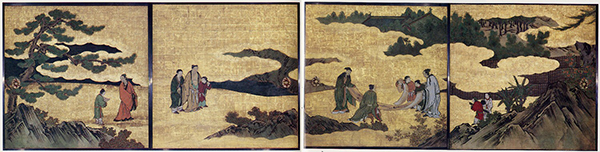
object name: screen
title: Appreciation of Painting, from a set of the Four Accomplishments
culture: japanese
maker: kano school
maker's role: artist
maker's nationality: japanese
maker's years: 1476-1559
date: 1606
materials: gold, gold leaf, ink, panel, paper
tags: men,landscapes,trees